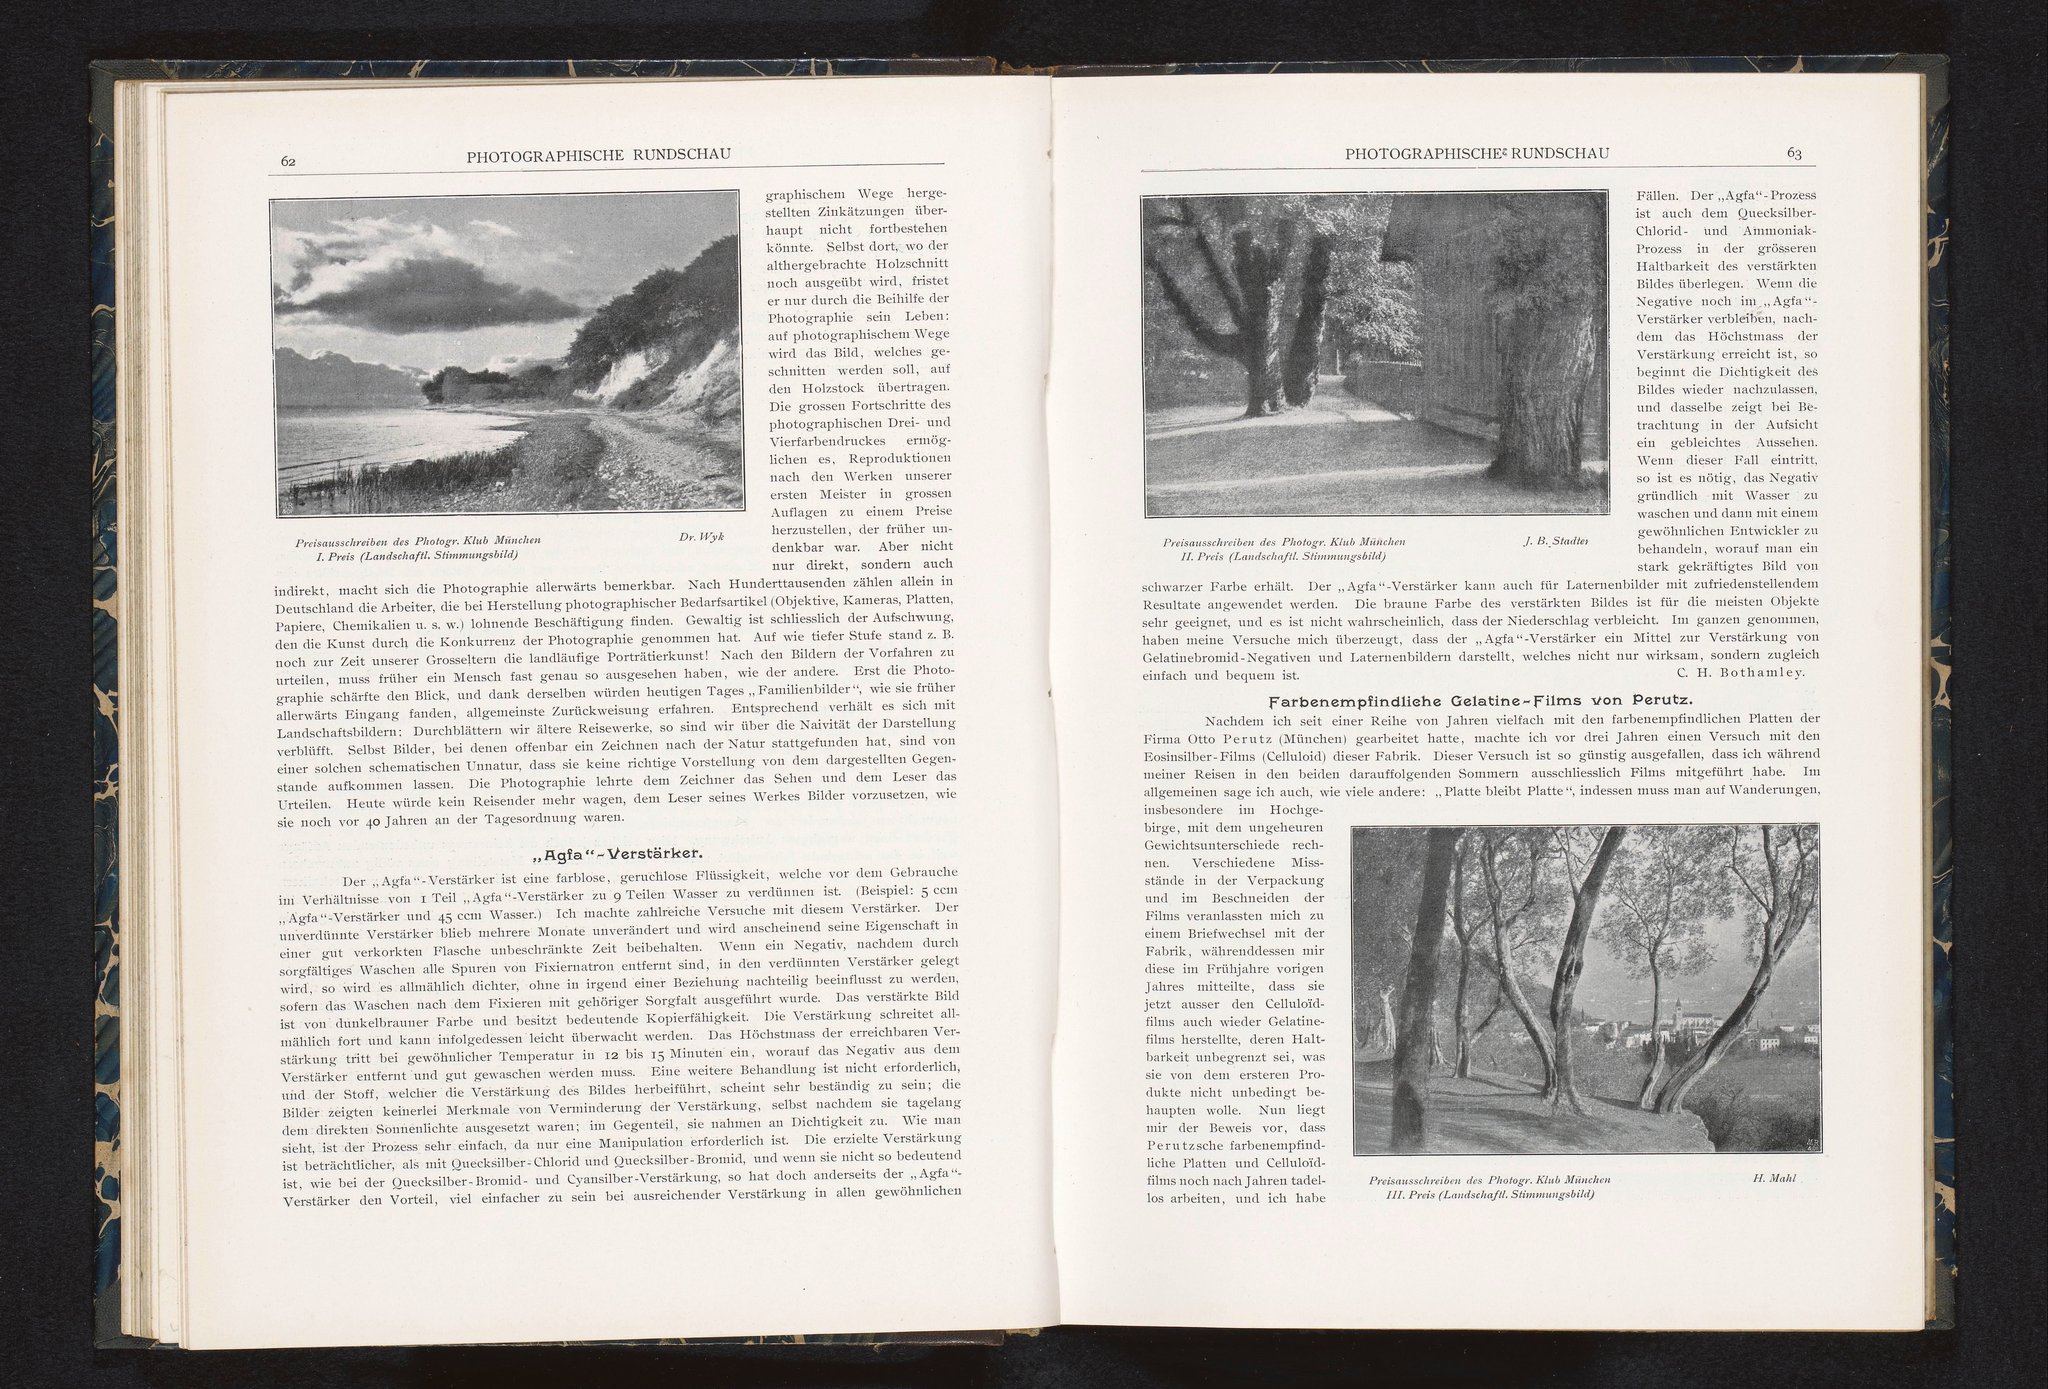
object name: photomechanical print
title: Preisausschreiben des Photogr. Klub München/ III. Preis (Landschaftl. Stimmungsbild)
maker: h. mahl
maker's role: fotograaf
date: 1896-1901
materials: paper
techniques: autotype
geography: berlin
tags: city-view, and landscape with man-made constructions, landscapes